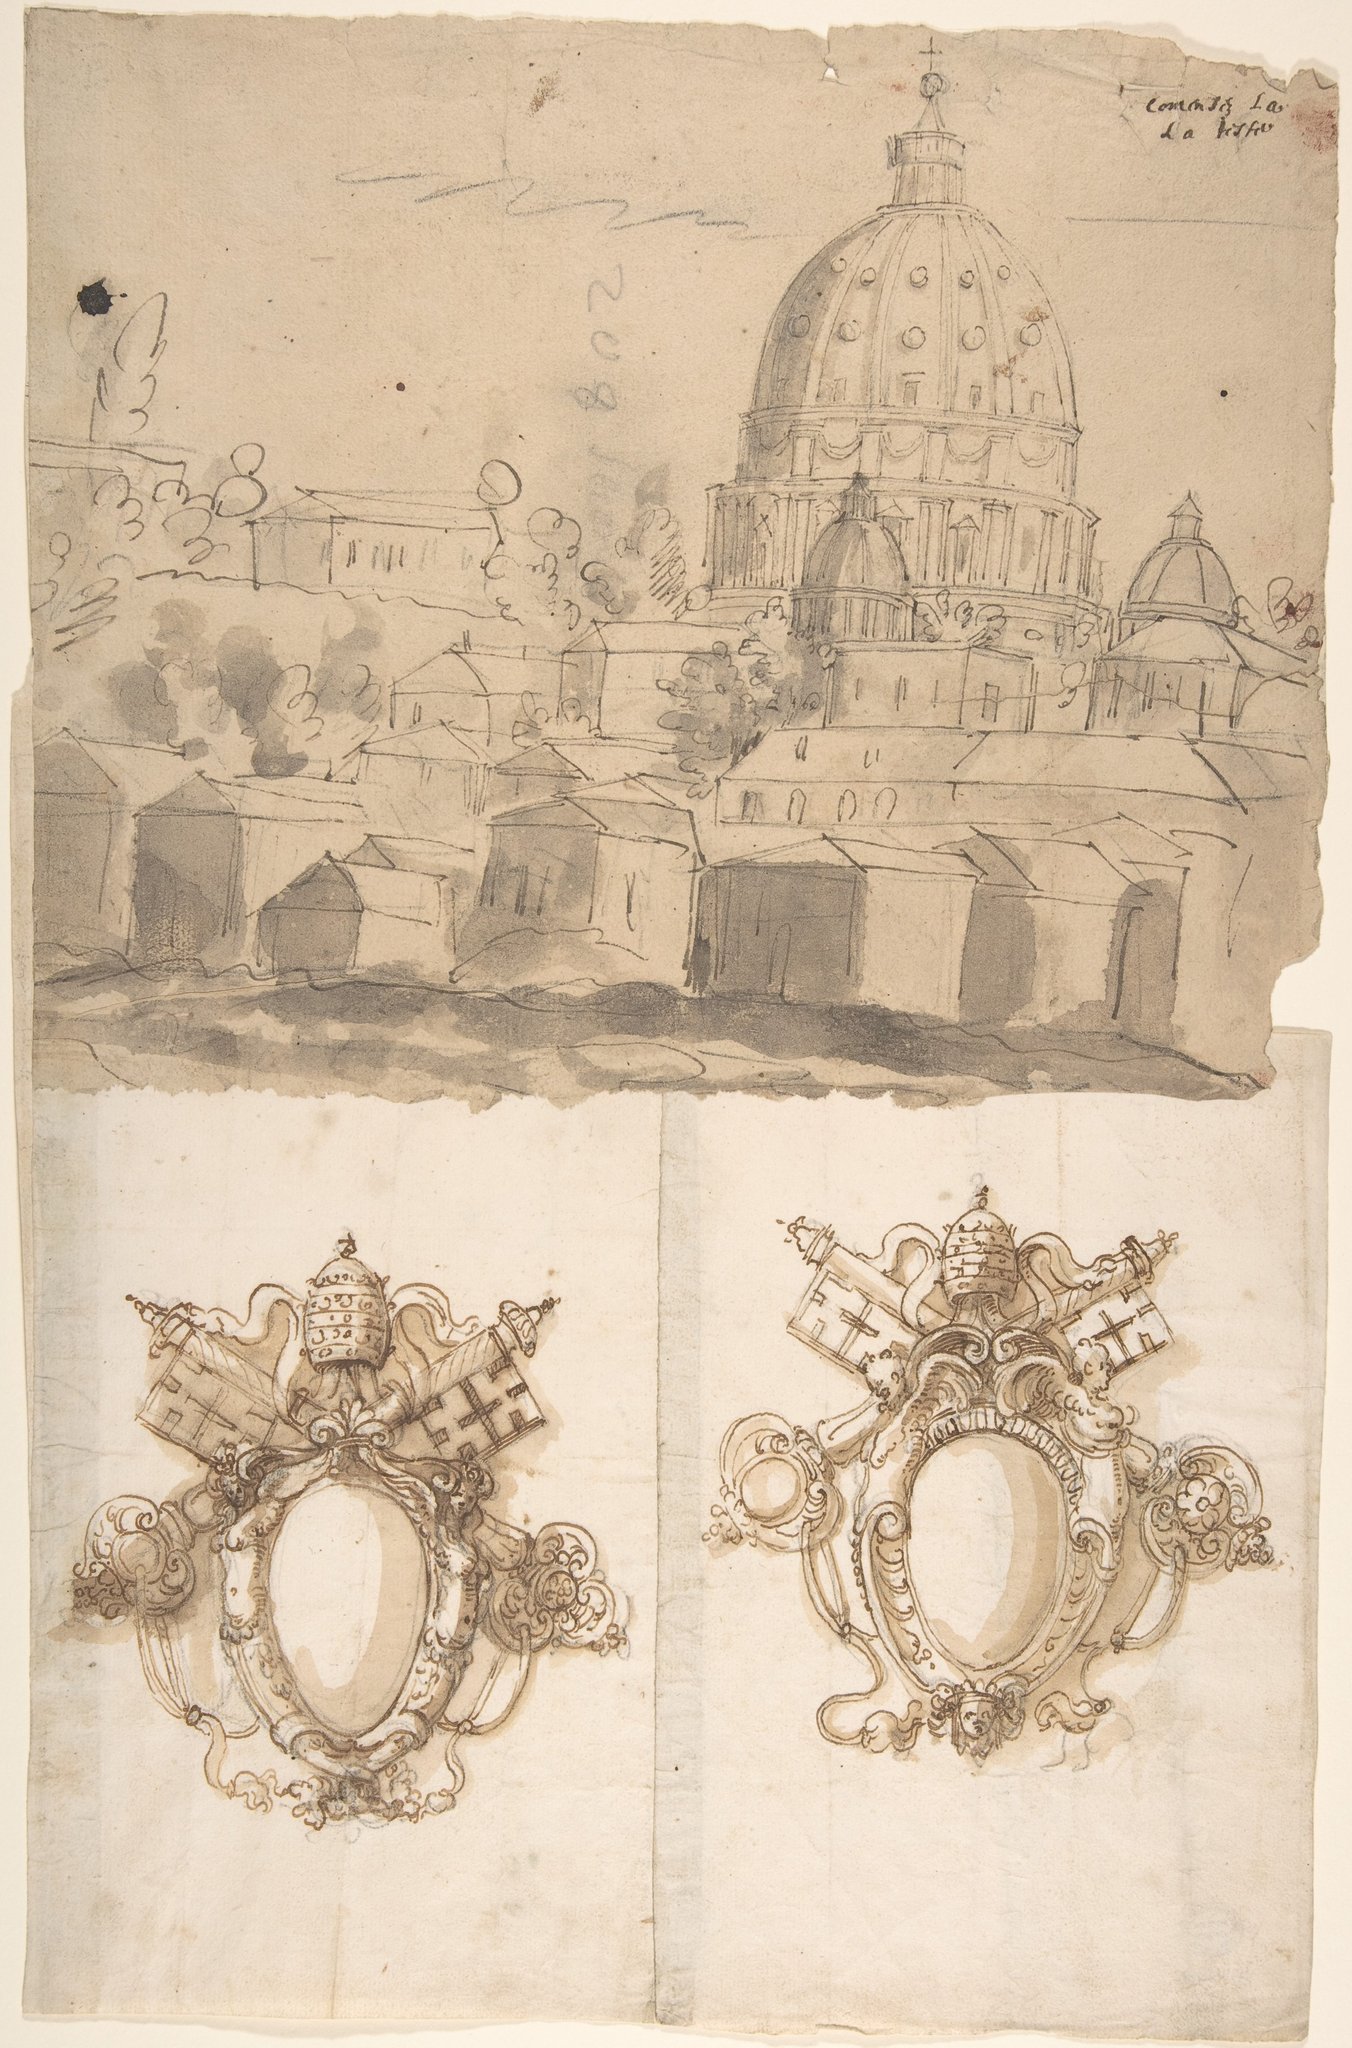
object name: drawing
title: St. Peter's, view from the southeast; Unidentified, blank, papal escutcheons (recto) blank (verso)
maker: anonymous, french, 16th century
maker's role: draftsman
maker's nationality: french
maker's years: 1500-1600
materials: chalk, ink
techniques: incising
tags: churches,coat of arms